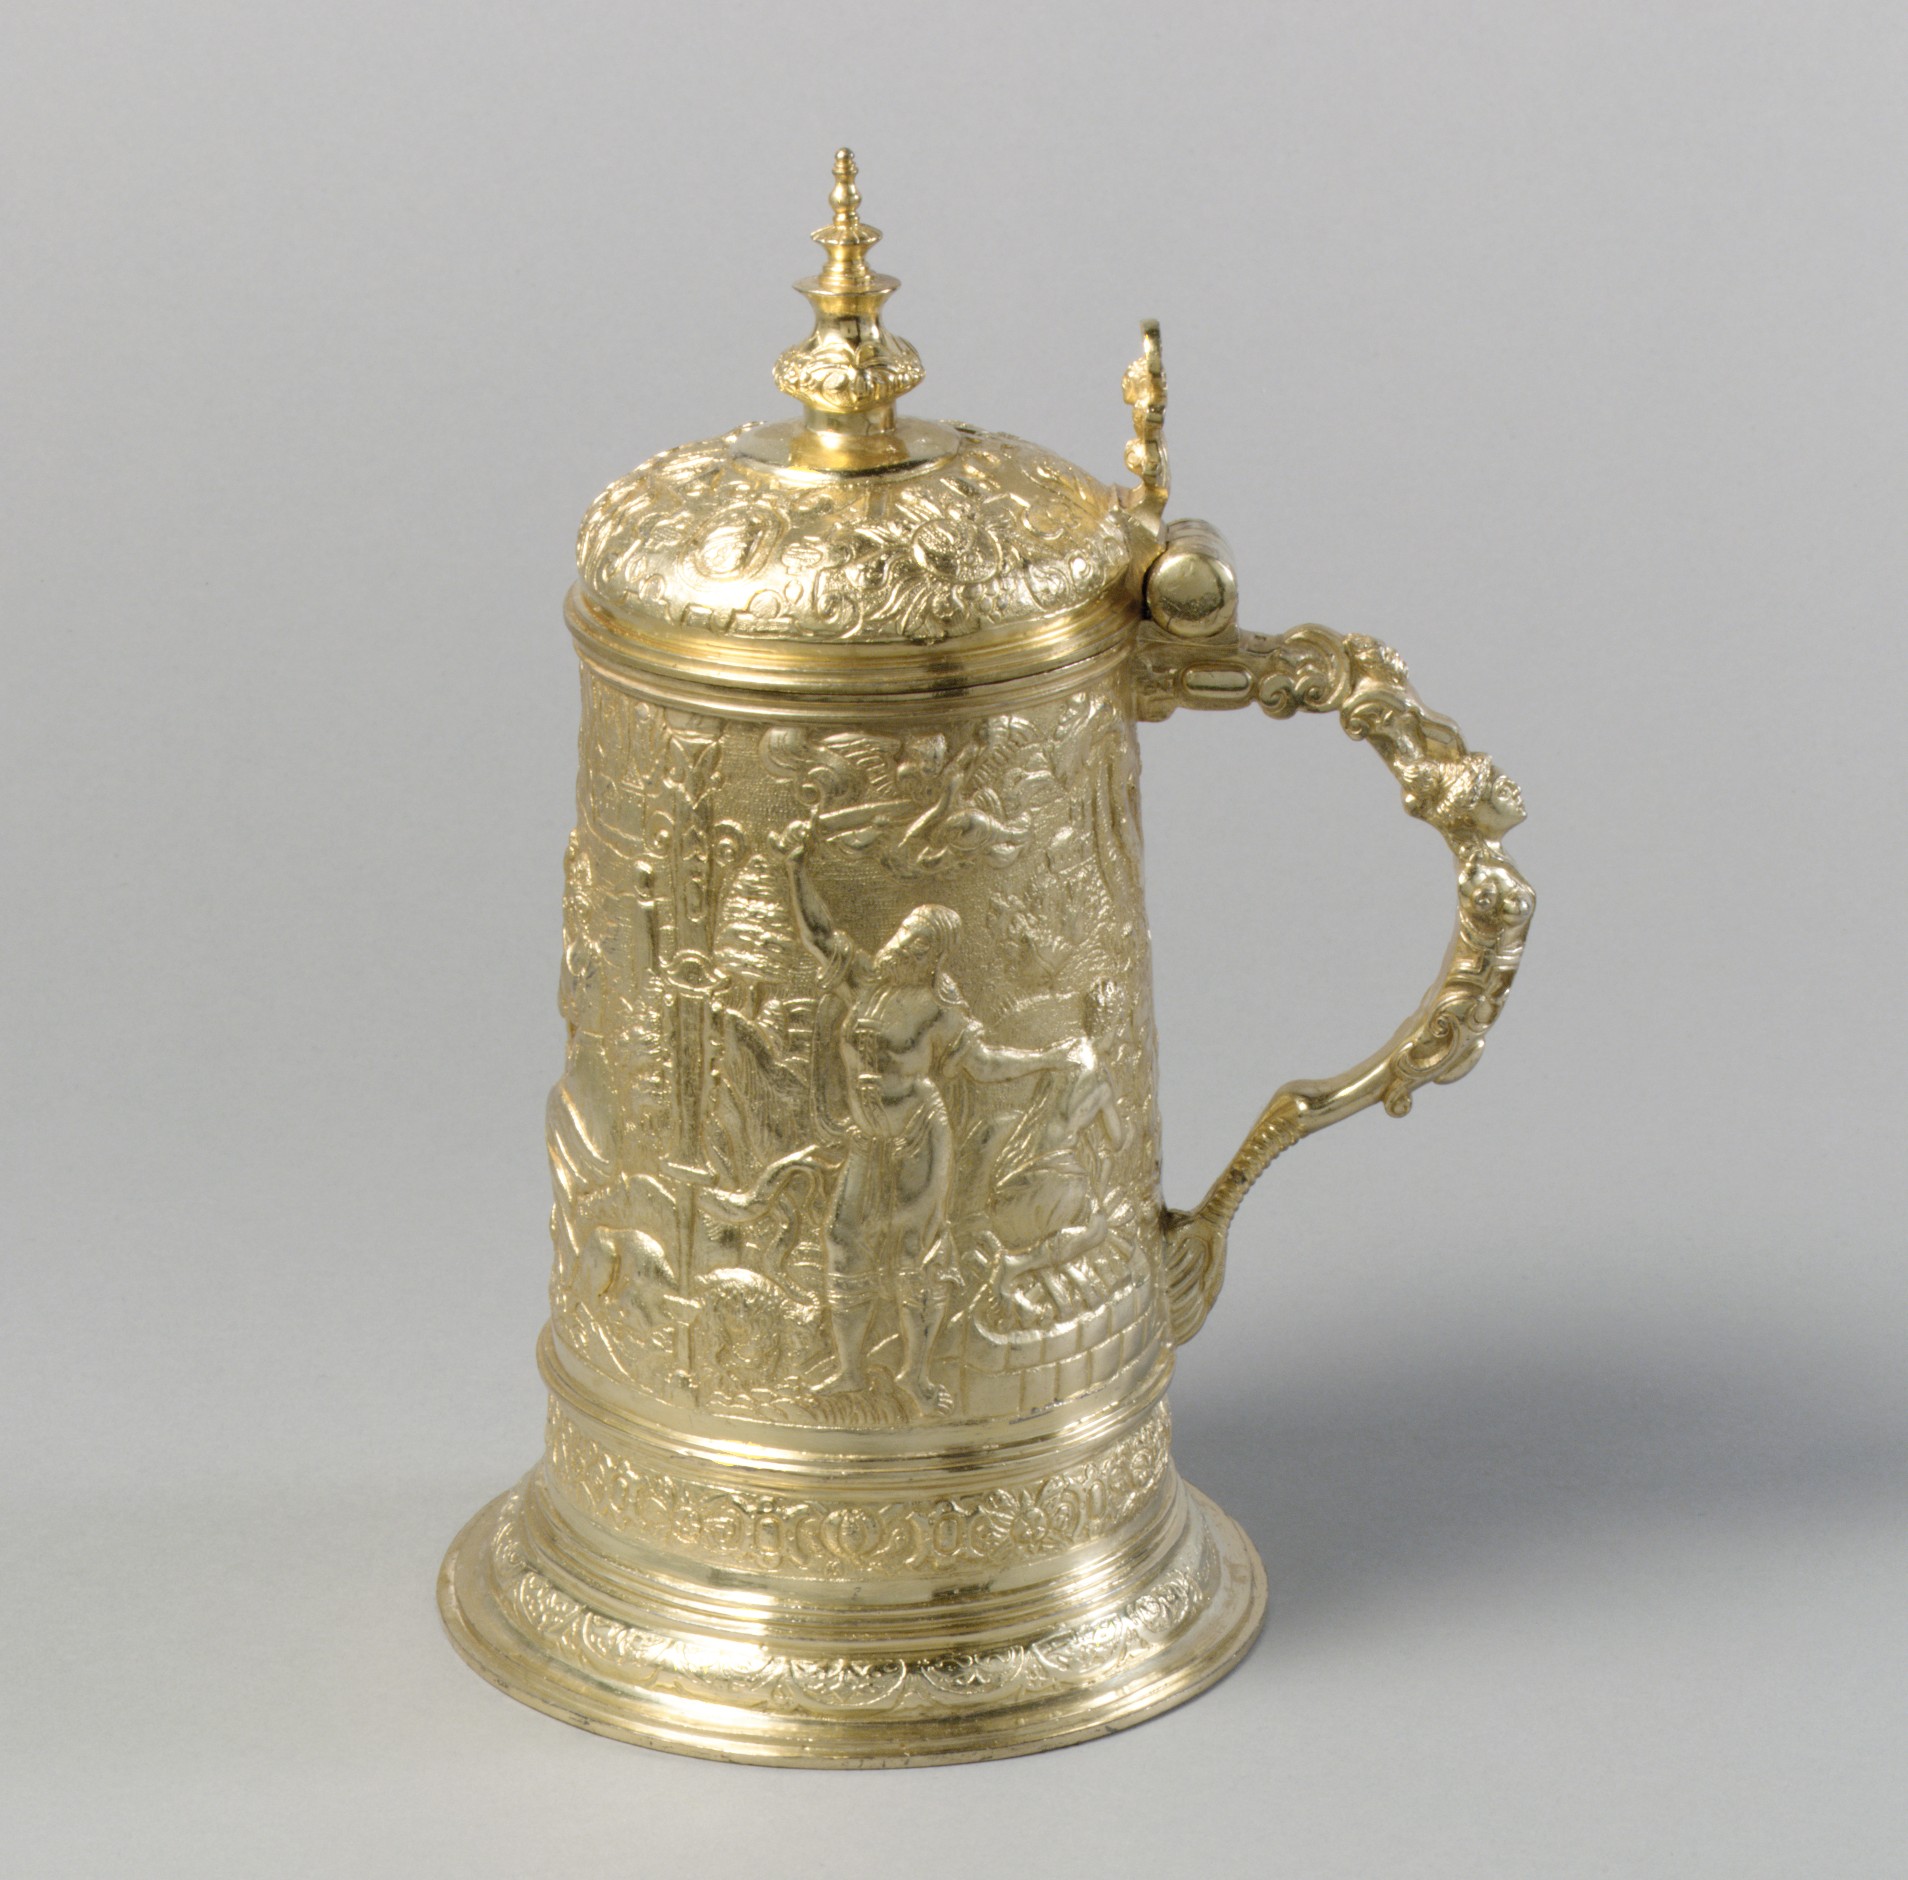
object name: tankard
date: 1801-1900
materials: metal, silver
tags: swords,men